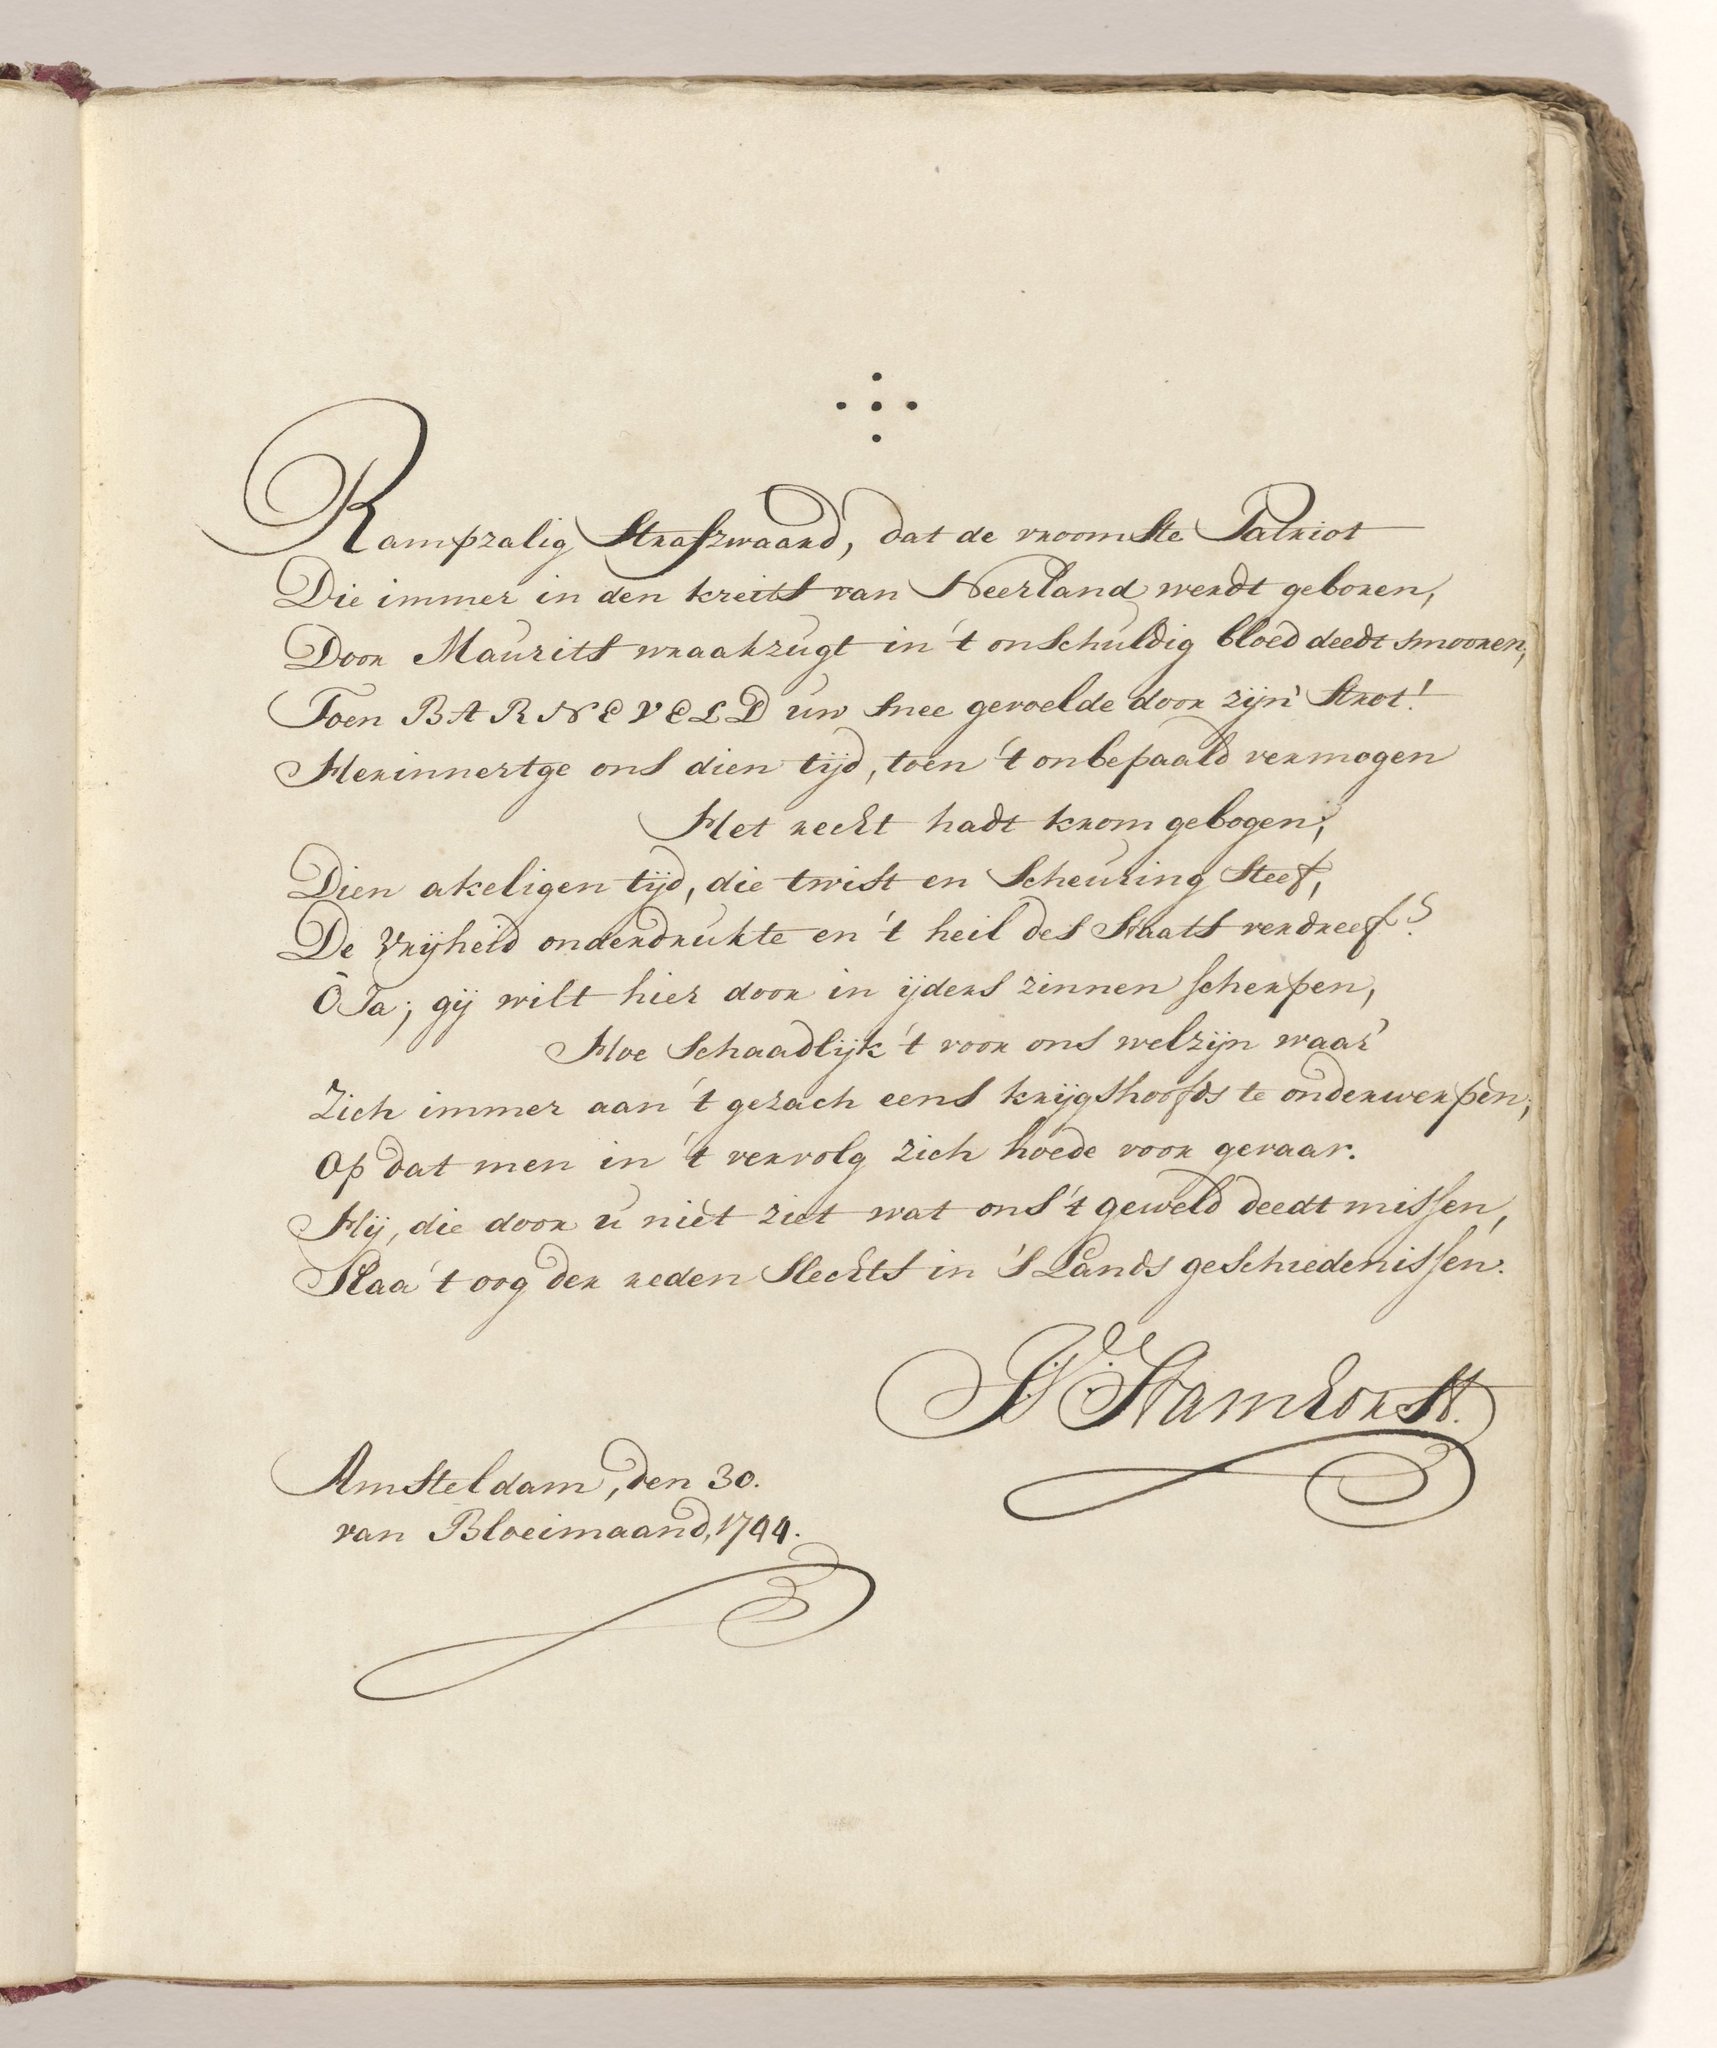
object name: manuscript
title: Gedicht op het zwaard waarmee Johan van Oldenbarnevelt in 1619 zou zijn onthoofd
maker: jacobus stamhorst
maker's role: dichter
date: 1744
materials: ink, paper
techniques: writing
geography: netherlands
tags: johan van oldenbarnevelt, rotterdam, dordrecht, print maker, frans greenwood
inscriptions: date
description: Vers van Jacobus Stamhorst. Onderdeel van het boek met gedichten uit de jaren 1743-1745 op het zwaard waarmee Johan van Oldenbarnevelt in 1619 zou zijn onthoofd. Het zwaard was eigendom van Frans Greenwood.